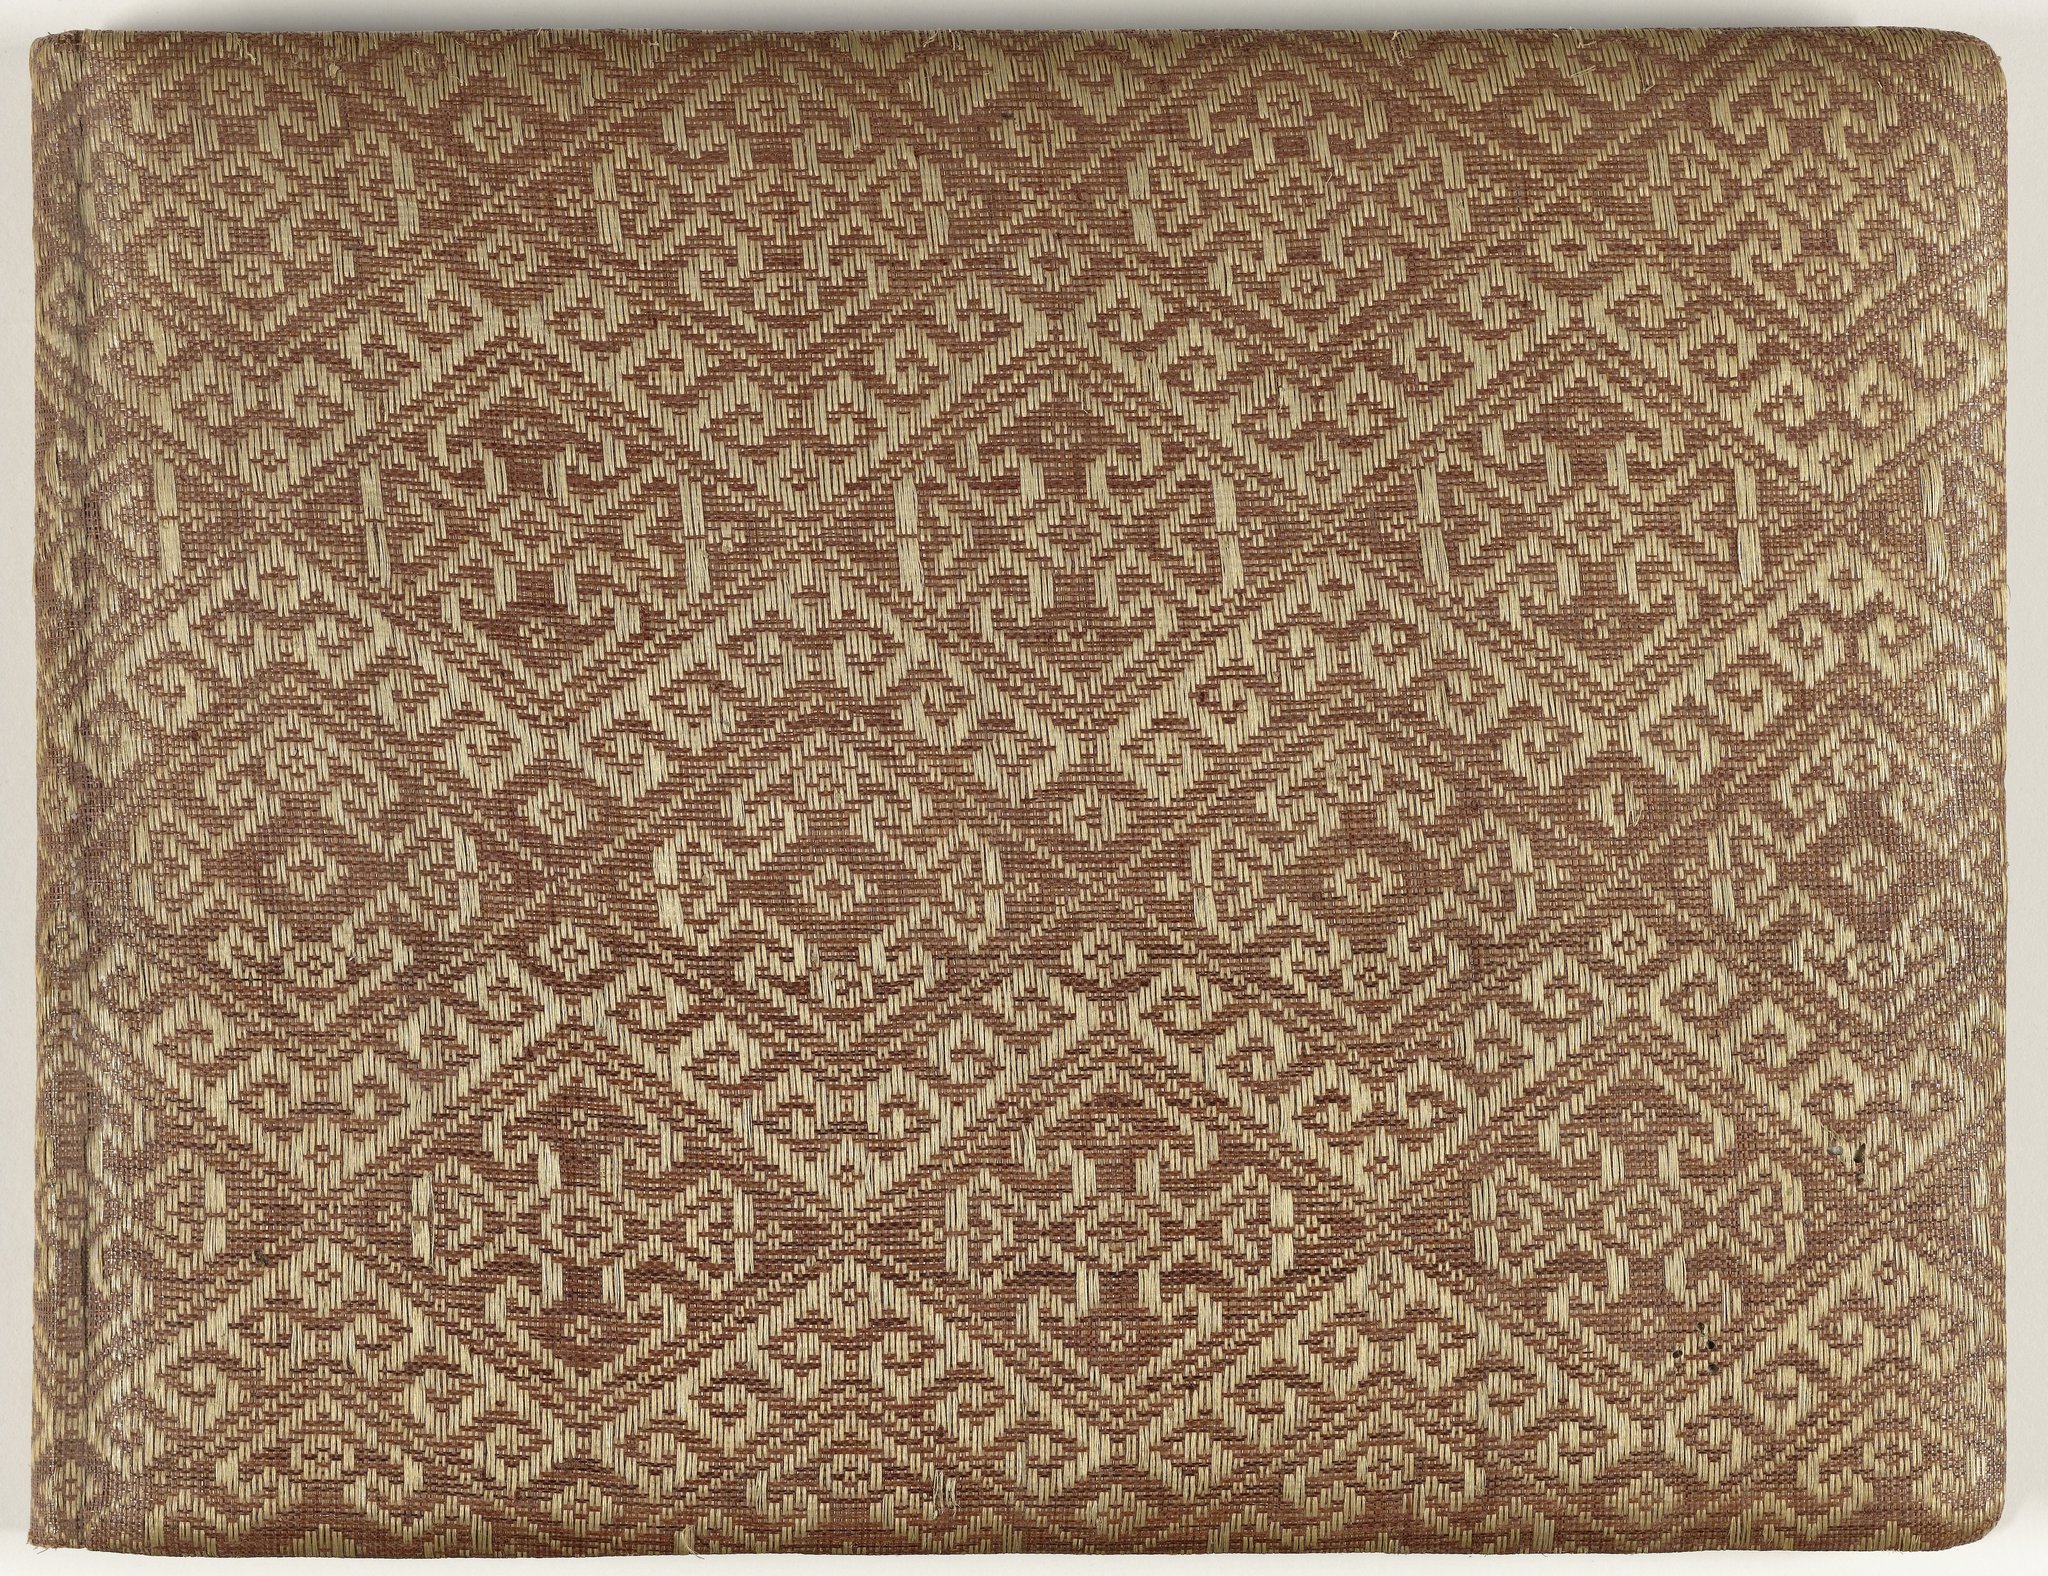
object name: photograph album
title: Album aangeboden aan dr. ir. H.M.J. Hart door personeel Centraal Kantoor voor de Statistiek te Batavia in 1935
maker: Anonymous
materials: paper, photographic support, textile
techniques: bookbinding, weave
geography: batavia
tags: leiden, batavia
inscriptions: inscription: ‘Omslag van Kofo-weefsel van de Sangir-eilanden’, inscription: ‘Den Heer Dr.Ir. J.M.J.Hart / bij zijn vertrek met Europeesch verlof op den / 20 sten Juli 1935 aangeboden door het personeel / van het Centraal Kantoor voor de Statistiek. / Batavia-Centrum, 16 juli 1935’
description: Album aangeboden door het personeel van het Centraal Kantoor voor de Statistiek aan dr. ir. H.M.J. Hart bij zijn vertrek naar Europa in 1935. Het kantoor in Batavia verzorgde het statistische onderzoek van de Directie Landbouw, Nijverheid en Handel.